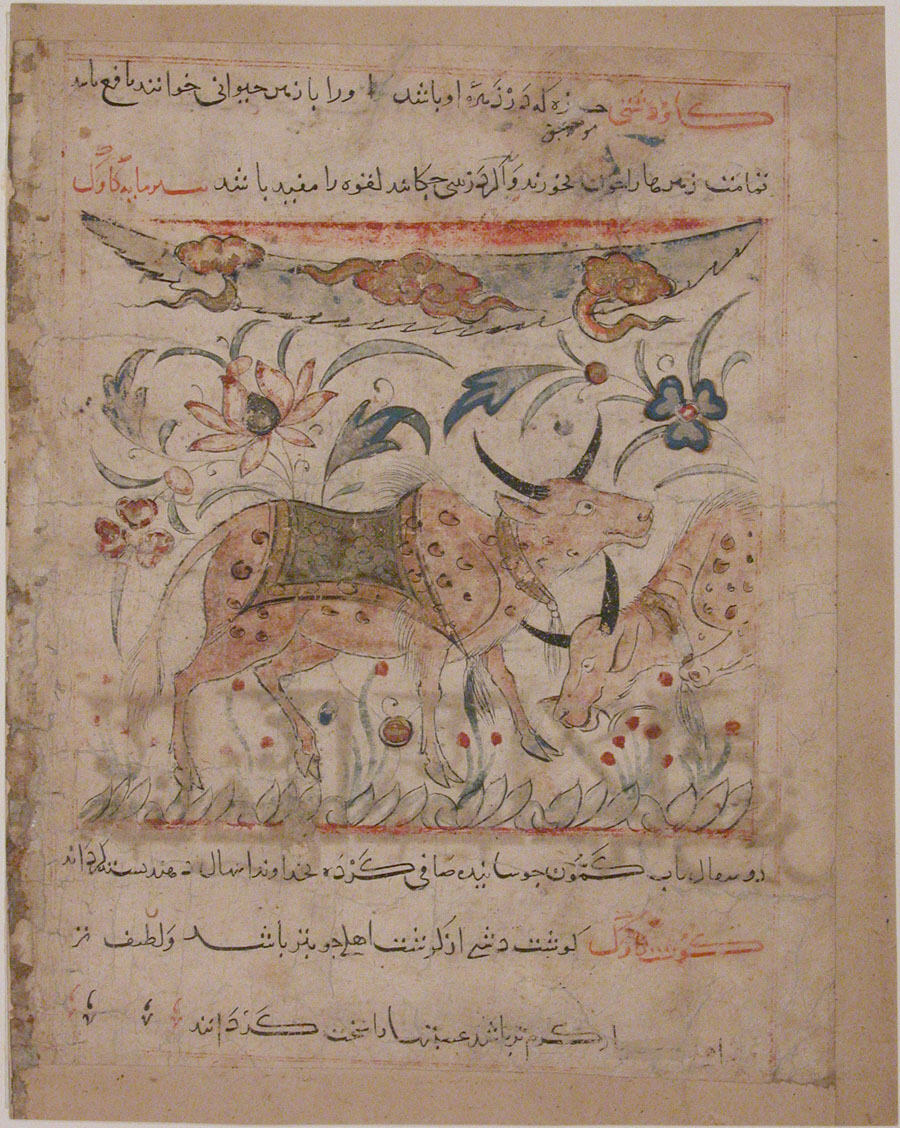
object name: folio from an illustrated manuscript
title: "Oxen amongst Foliage", Folio from a Manafi' al-Hayawan (On the Usefulness of Animals) of Ibn Bakhtishu'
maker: ibn bakhtishu'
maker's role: author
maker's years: 958-1058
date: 1297-1299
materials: gold, ink, paper, watercolor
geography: iran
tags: ox